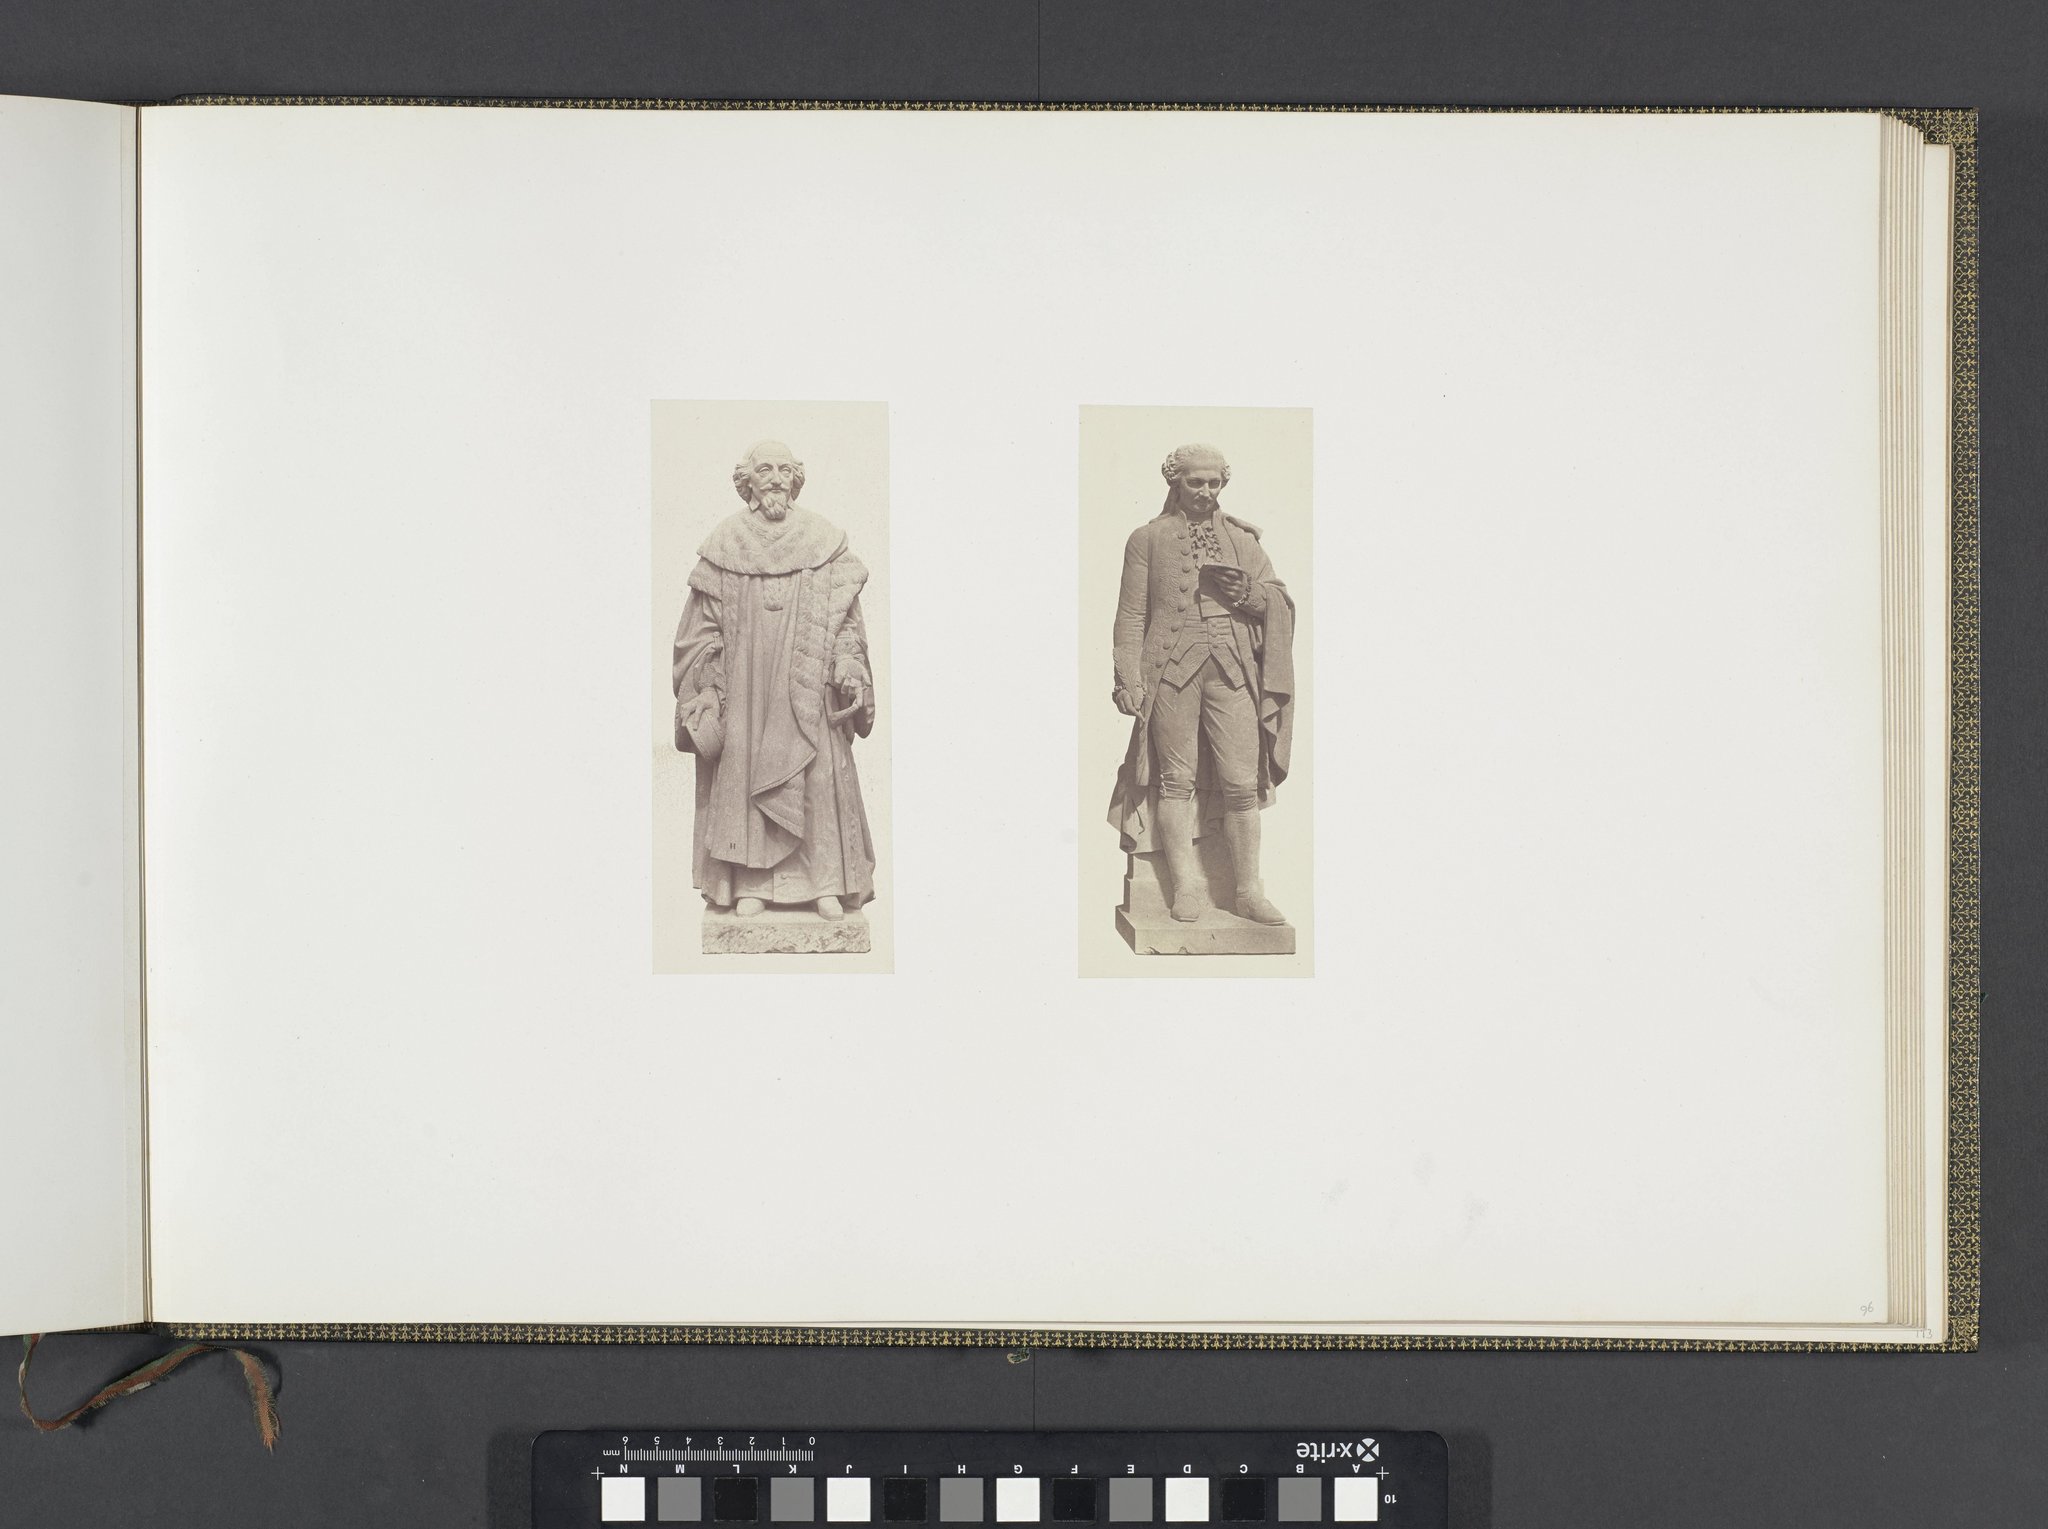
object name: photograph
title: Gipsmodellen voor beeldhouwwerken op het Palais du Louvre: links "Molé" door Nanteuil en rechts "Turgot" door Pierre Travaux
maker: édouard denis baldus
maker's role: fotograaf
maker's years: 1813-1889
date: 1855-1857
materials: paper, photographic support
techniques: salted paper print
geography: paris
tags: piece of sculpture, reproduction of a piece of sculpture, permanent exhibition, museum, paris, tuileries palace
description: Onderdeel van Réunion des Tuileries au Louvre 1852-1857, album 1.